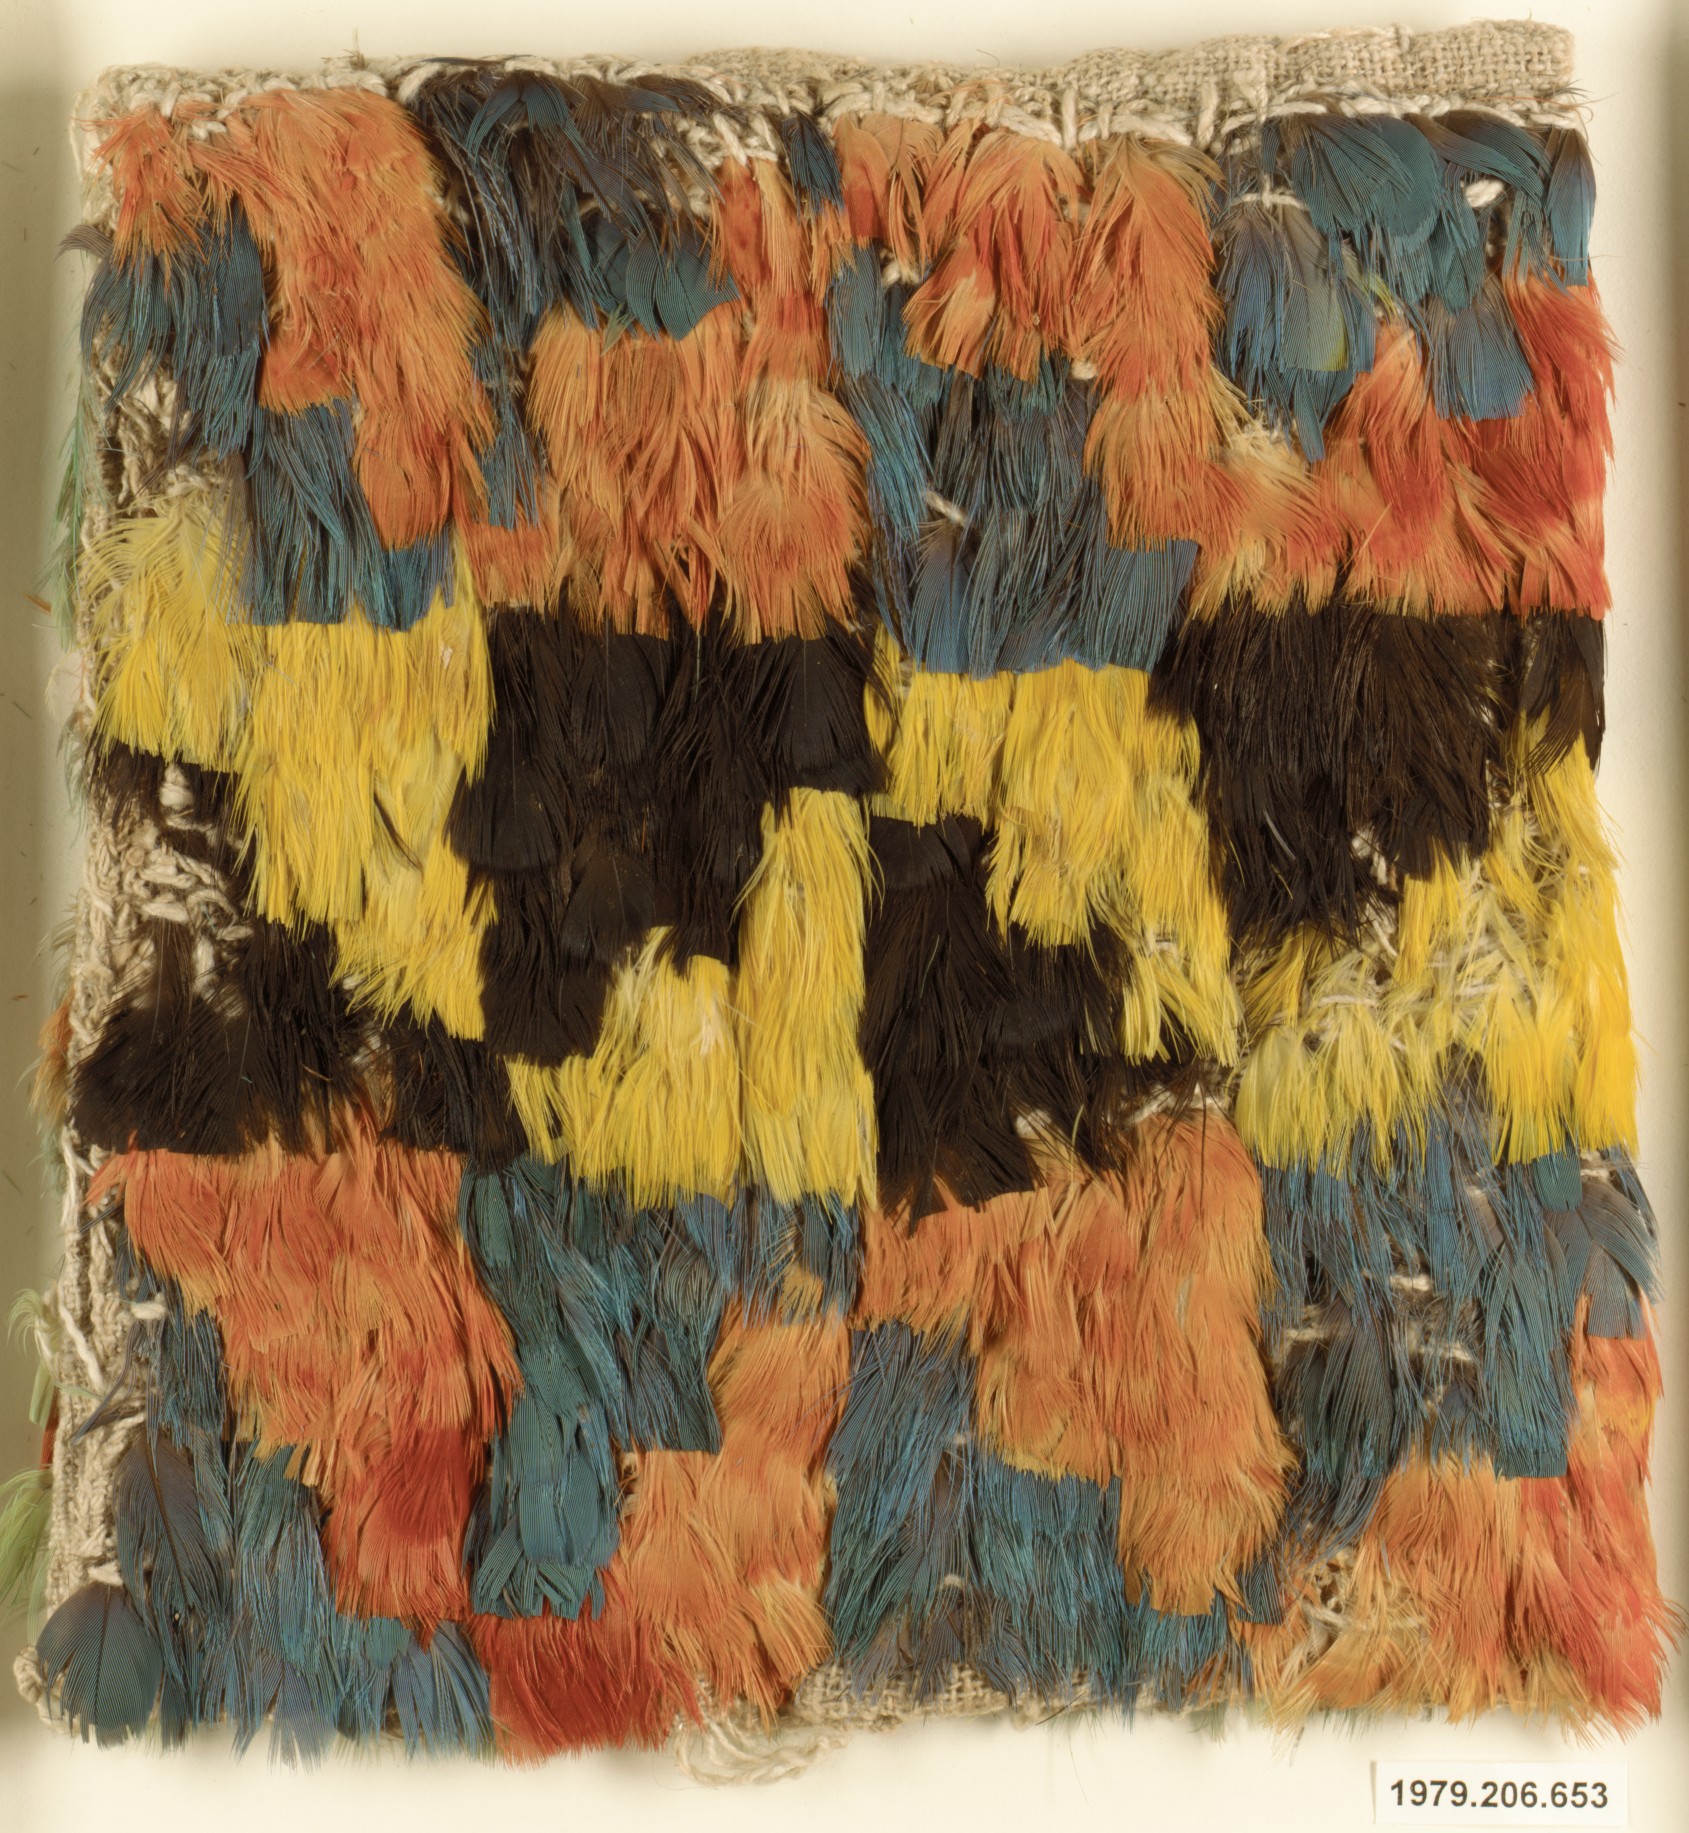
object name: miniature dress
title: Miniature Feathered Dress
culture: ica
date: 1101-1300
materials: cotton, feather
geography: peru